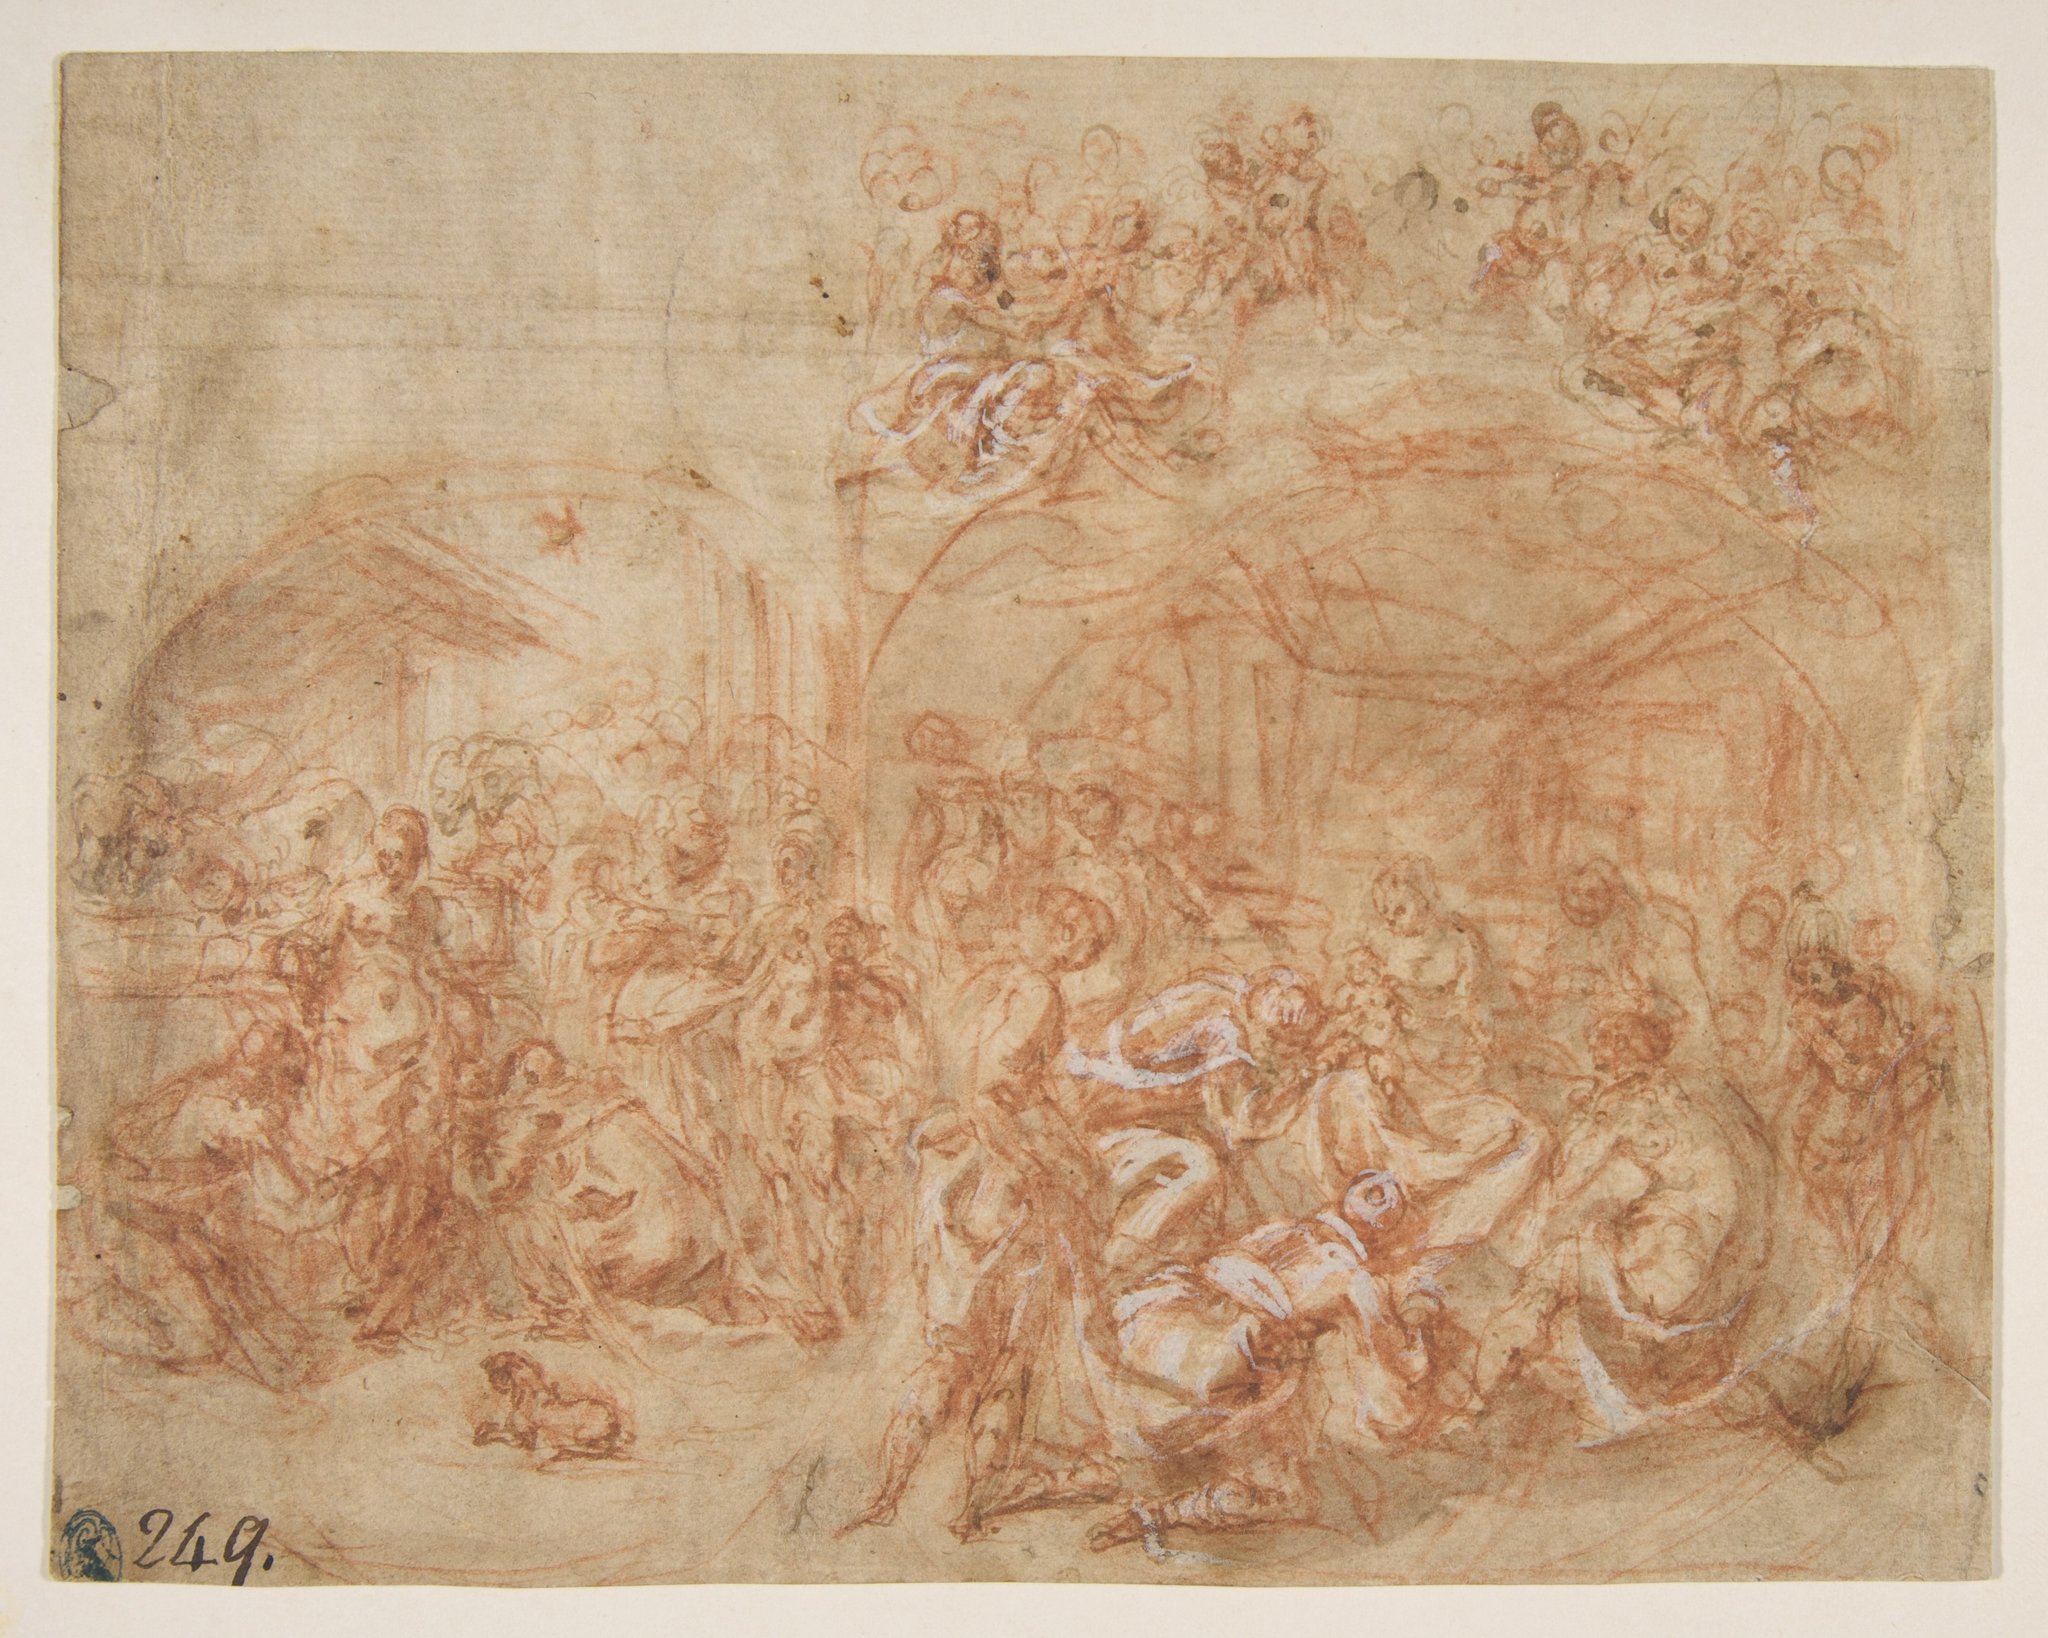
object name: drawing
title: Adoration of the Magi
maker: cesare pollino (cesare dal francia or franchi)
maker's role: artist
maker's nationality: italian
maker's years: 1555-1598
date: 1560-1630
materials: chalk, paper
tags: adoration of the magi